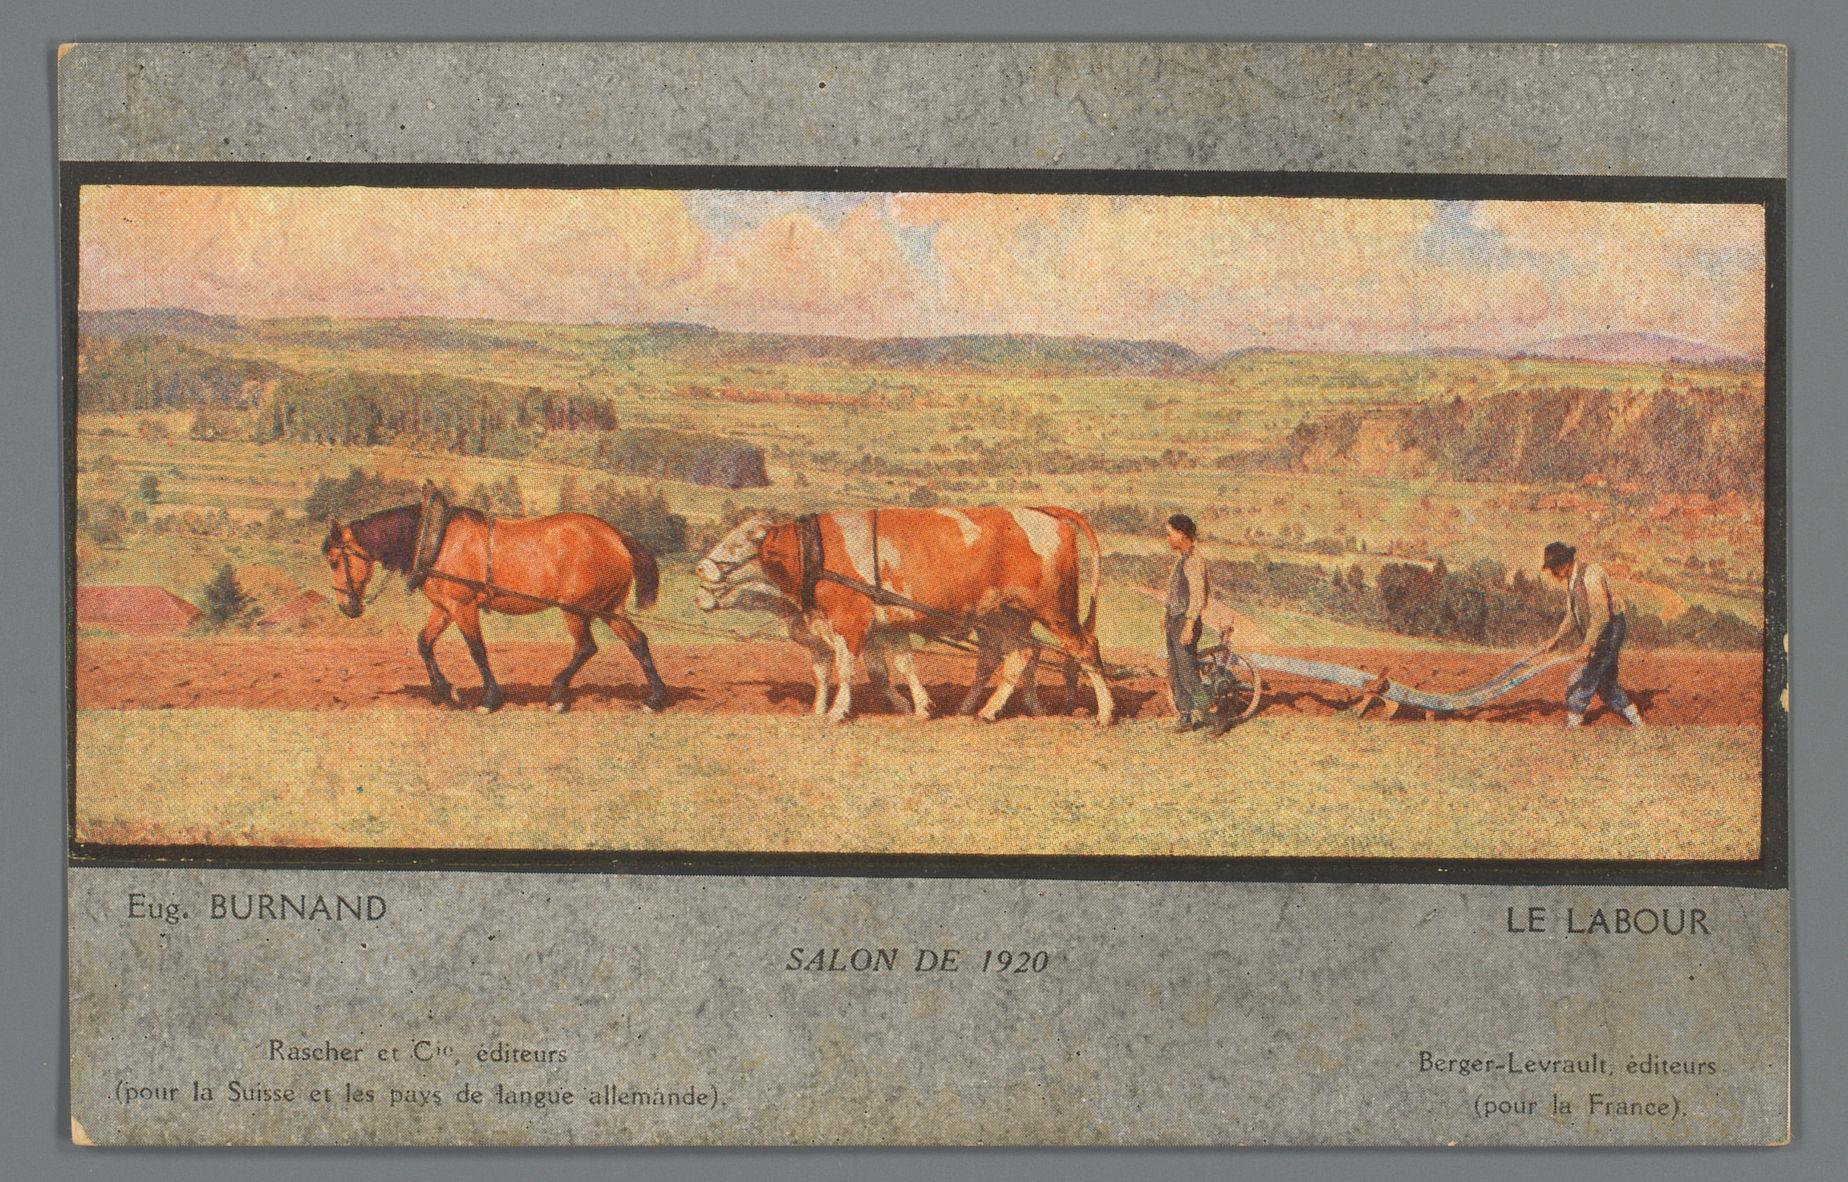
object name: photomechanical print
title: Le labour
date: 1920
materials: cardboard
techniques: four-color autotype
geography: zurich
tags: ploughing